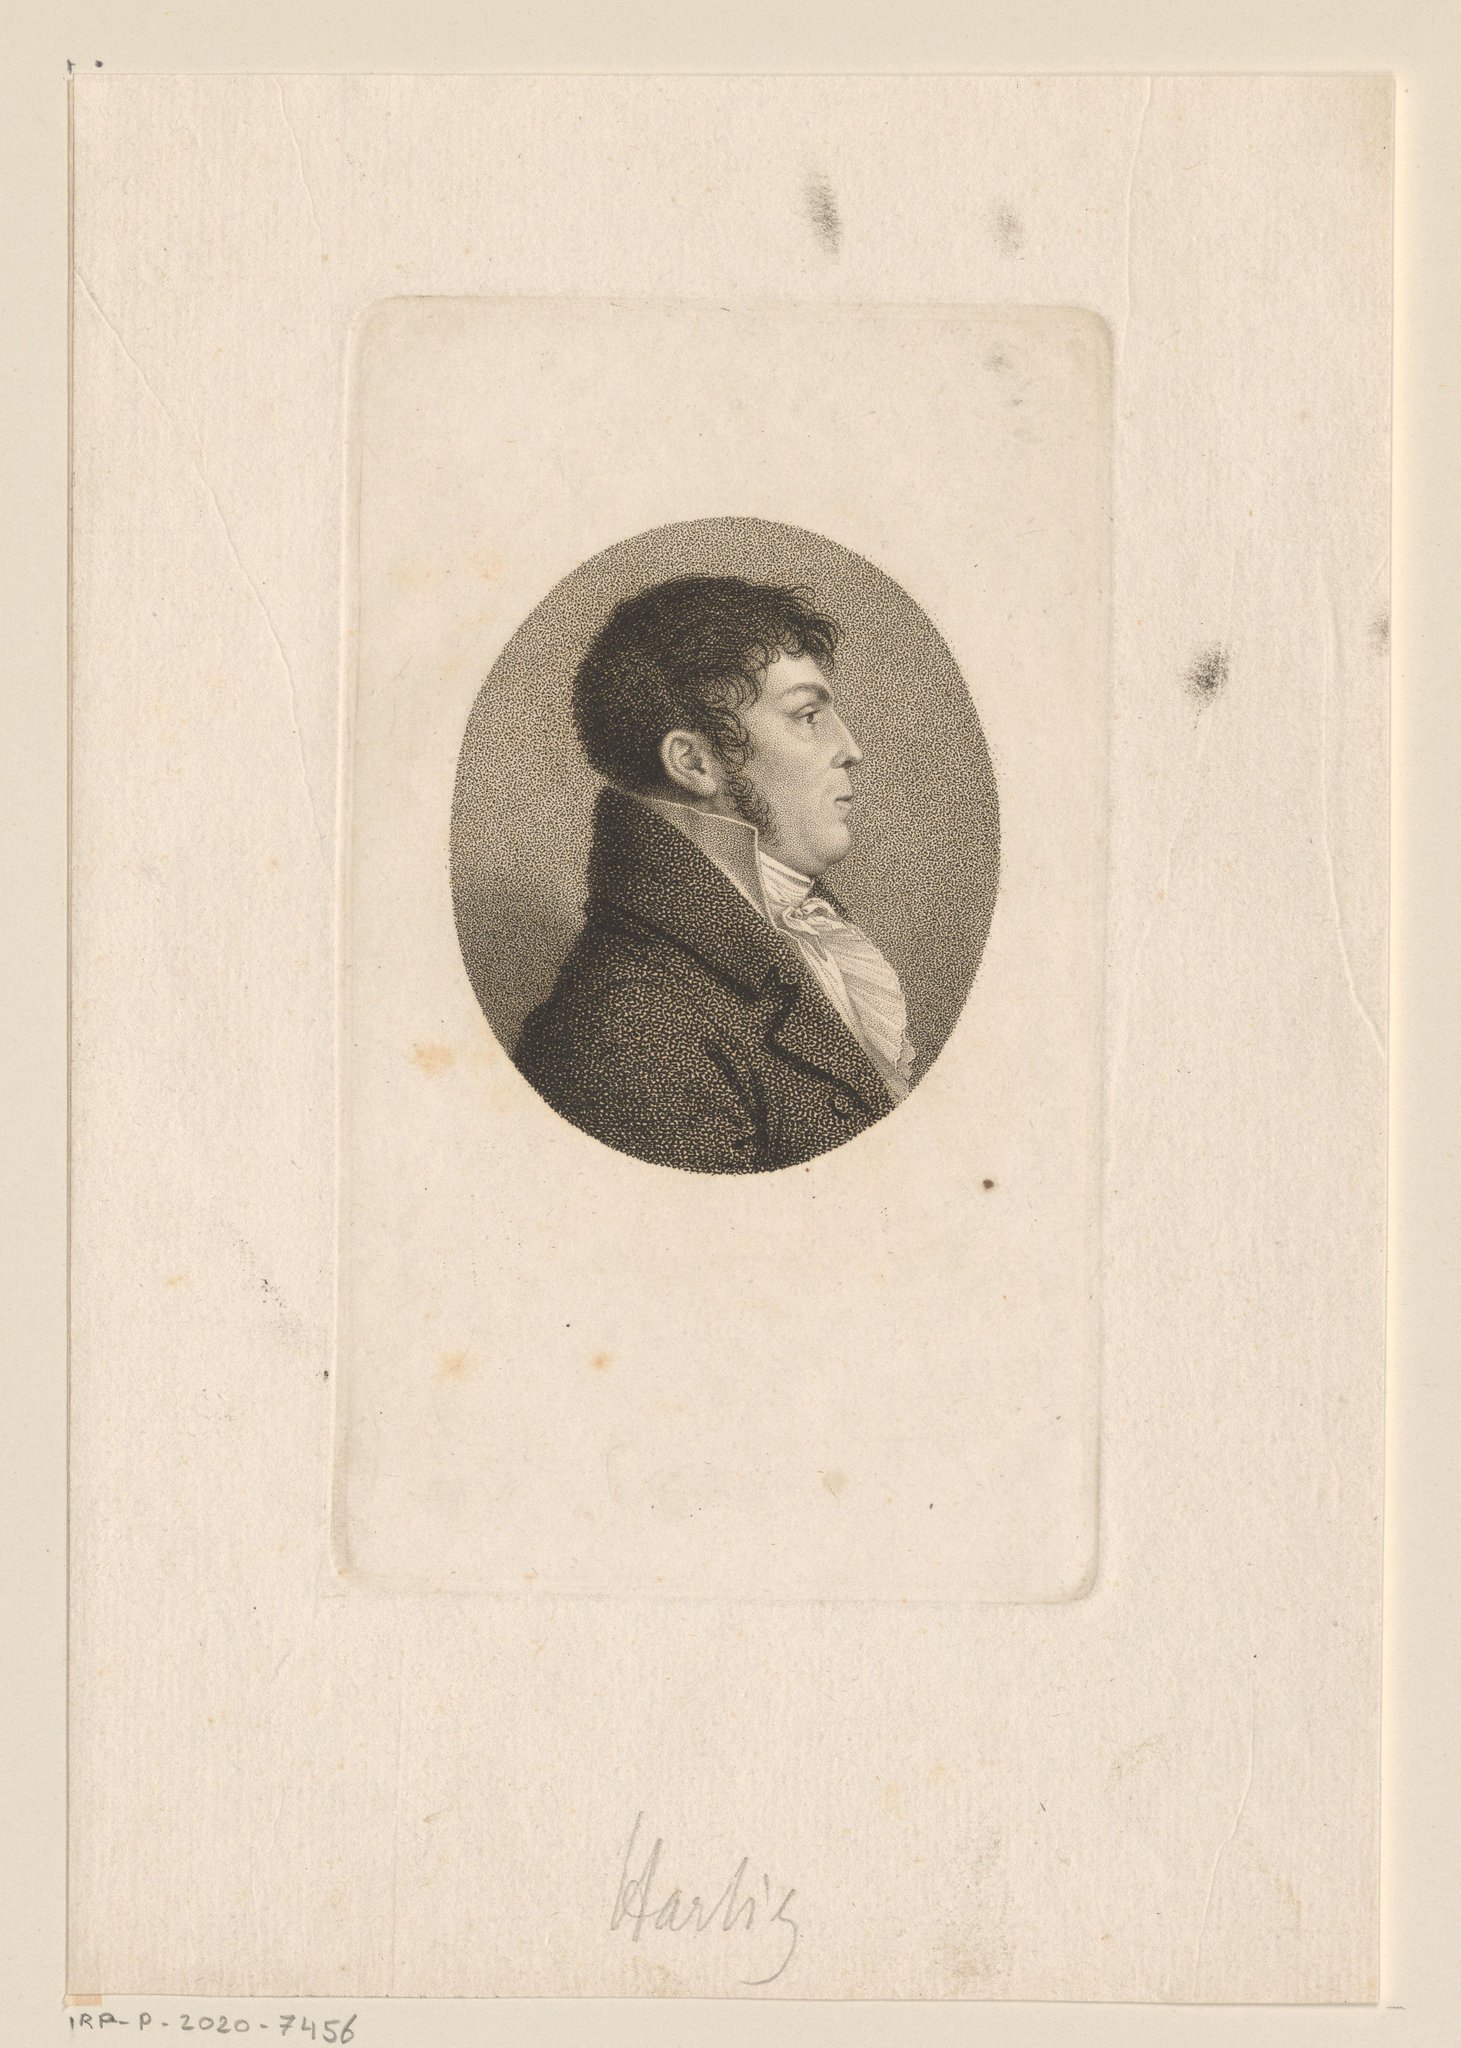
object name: print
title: Portret van mogelijk Georg Ludwig Hartig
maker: Anonymous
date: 1785-1849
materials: paper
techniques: engraving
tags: berlin, forester, historical persons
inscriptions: inscription: ‘Hartig’